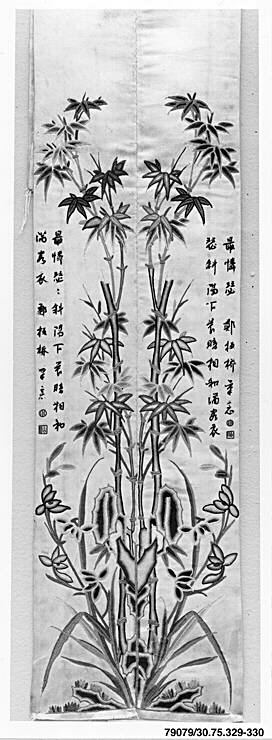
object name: sleeve band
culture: chinese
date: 1801-1900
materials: silk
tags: bamboo